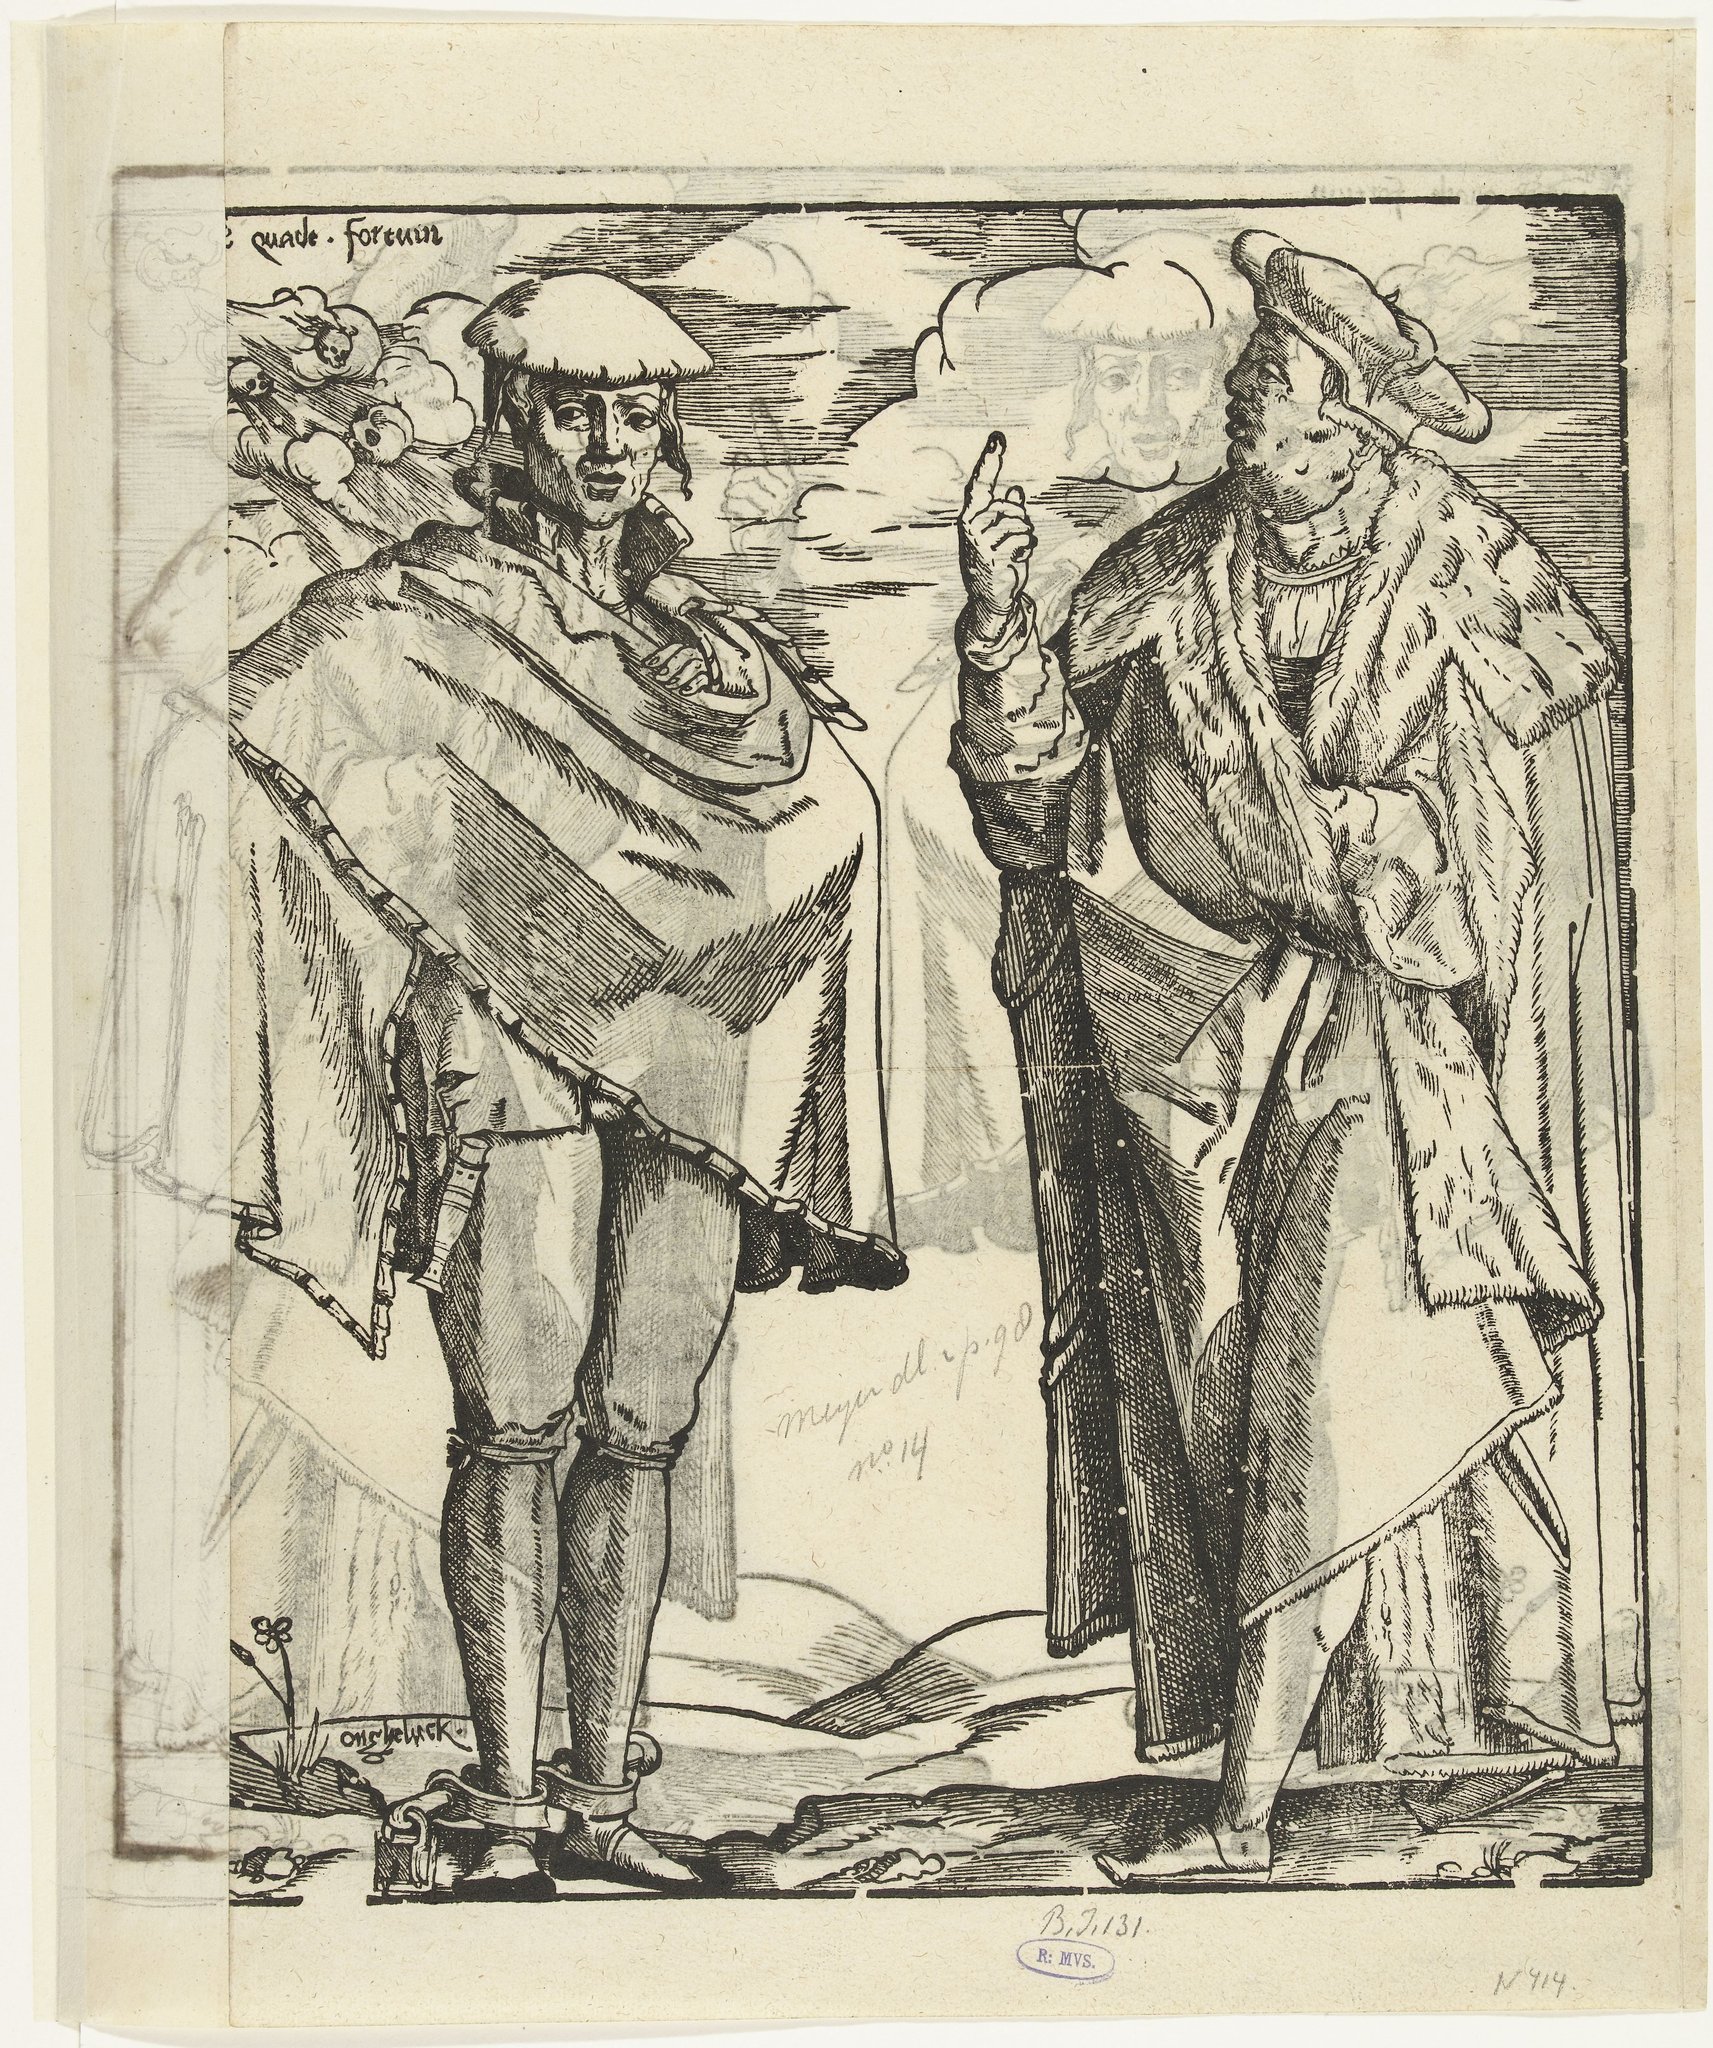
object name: print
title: De lichtzinnige jeugd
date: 1542-1546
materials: paper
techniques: woodcut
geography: amsterdam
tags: adversity, misfortune, bad luck; 'fortuna infelice', 'infortunio' (ripa), youth, adolescent, (person) in fetters, not imprisoned, frivolity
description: Vierde blok, onderdeel van een fries van vier blokken. Jongeman geketend door "ongeluck" en "quade fortuin" wordt hem toegeblazen. Naast hem een raadsheer als vertegenwoordiger van de aardse gerechtigheid.